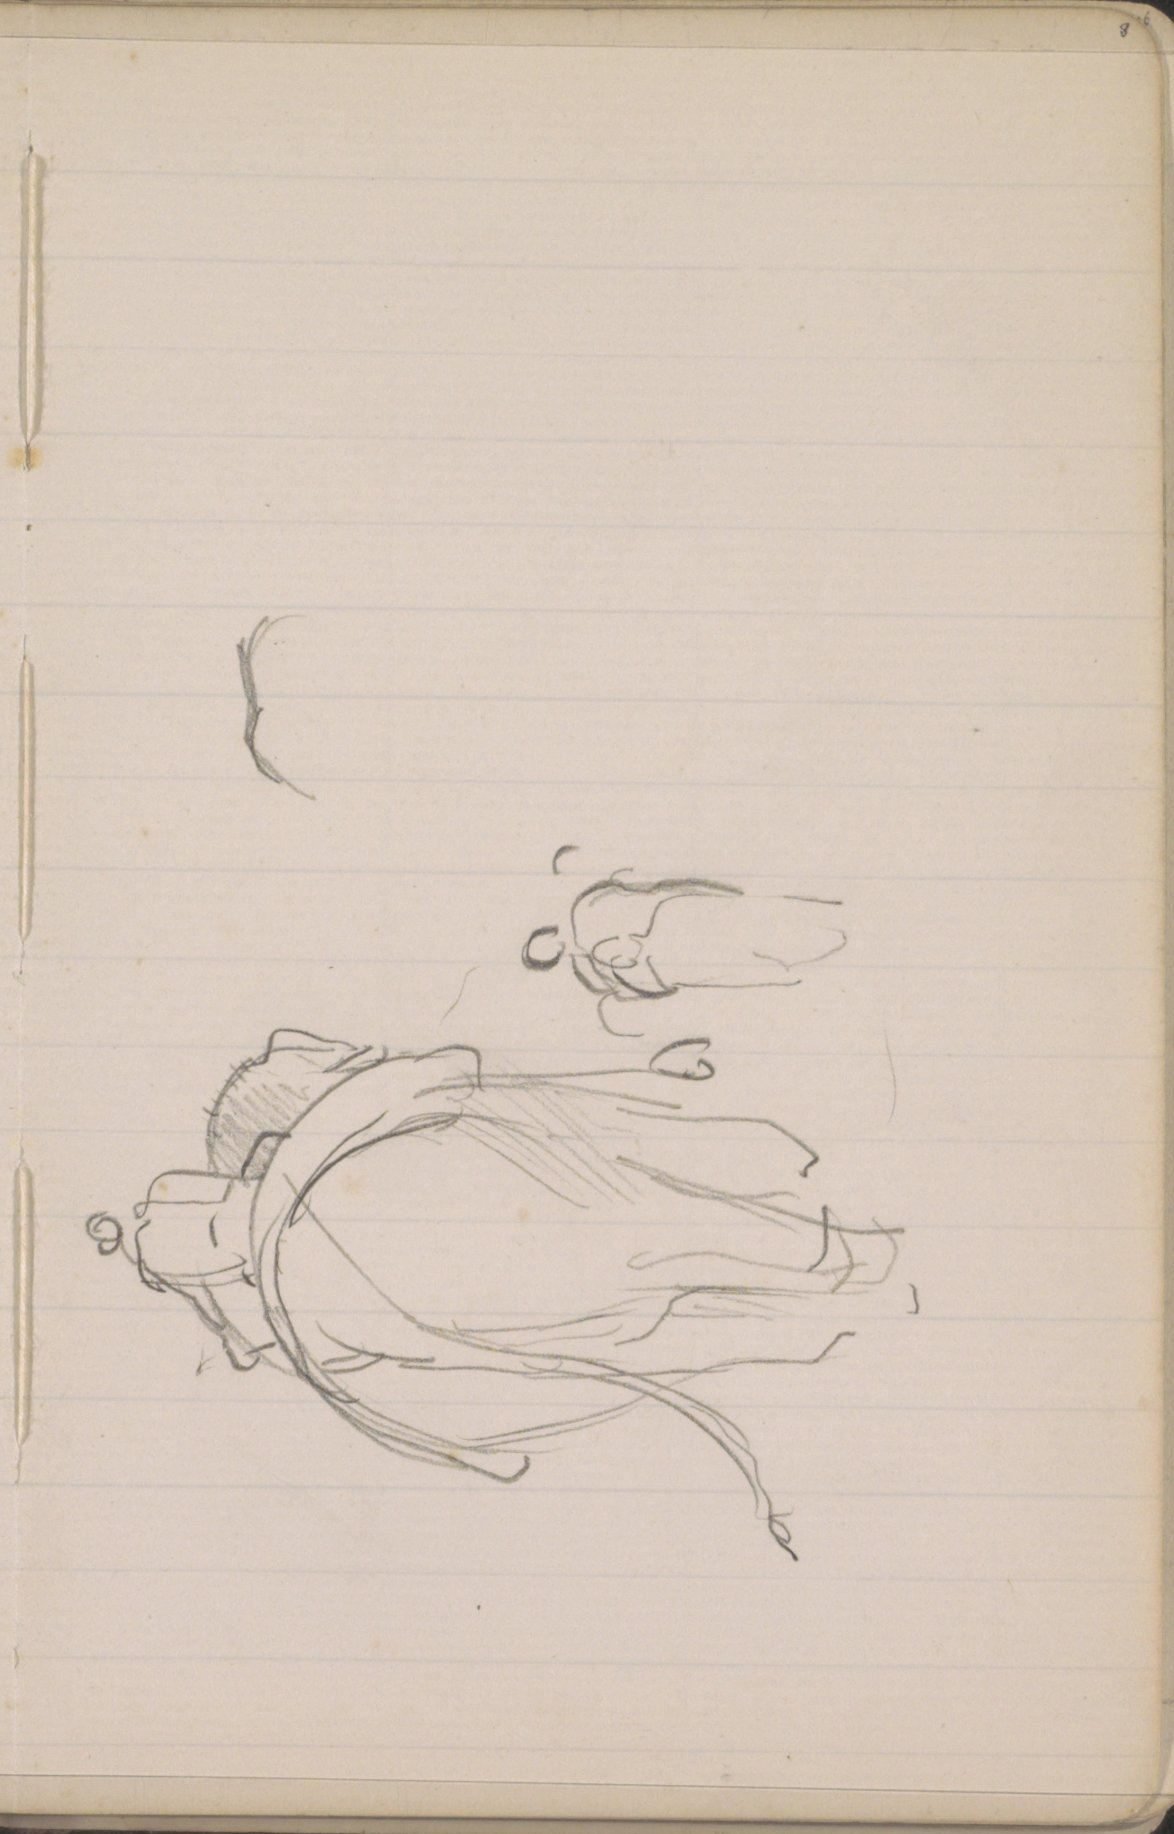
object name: sketchbook leaf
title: Figuur op een olifant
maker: marius bauer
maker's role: draughtsman, print maker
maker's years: 1867-1932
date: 1897-1898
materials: pencil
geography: india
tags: standing figure, sitting figure, trunked animals: elephant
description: Naast de olifant een staande figuur. Pagina 8 uit een schetsboek met 84 bladen.